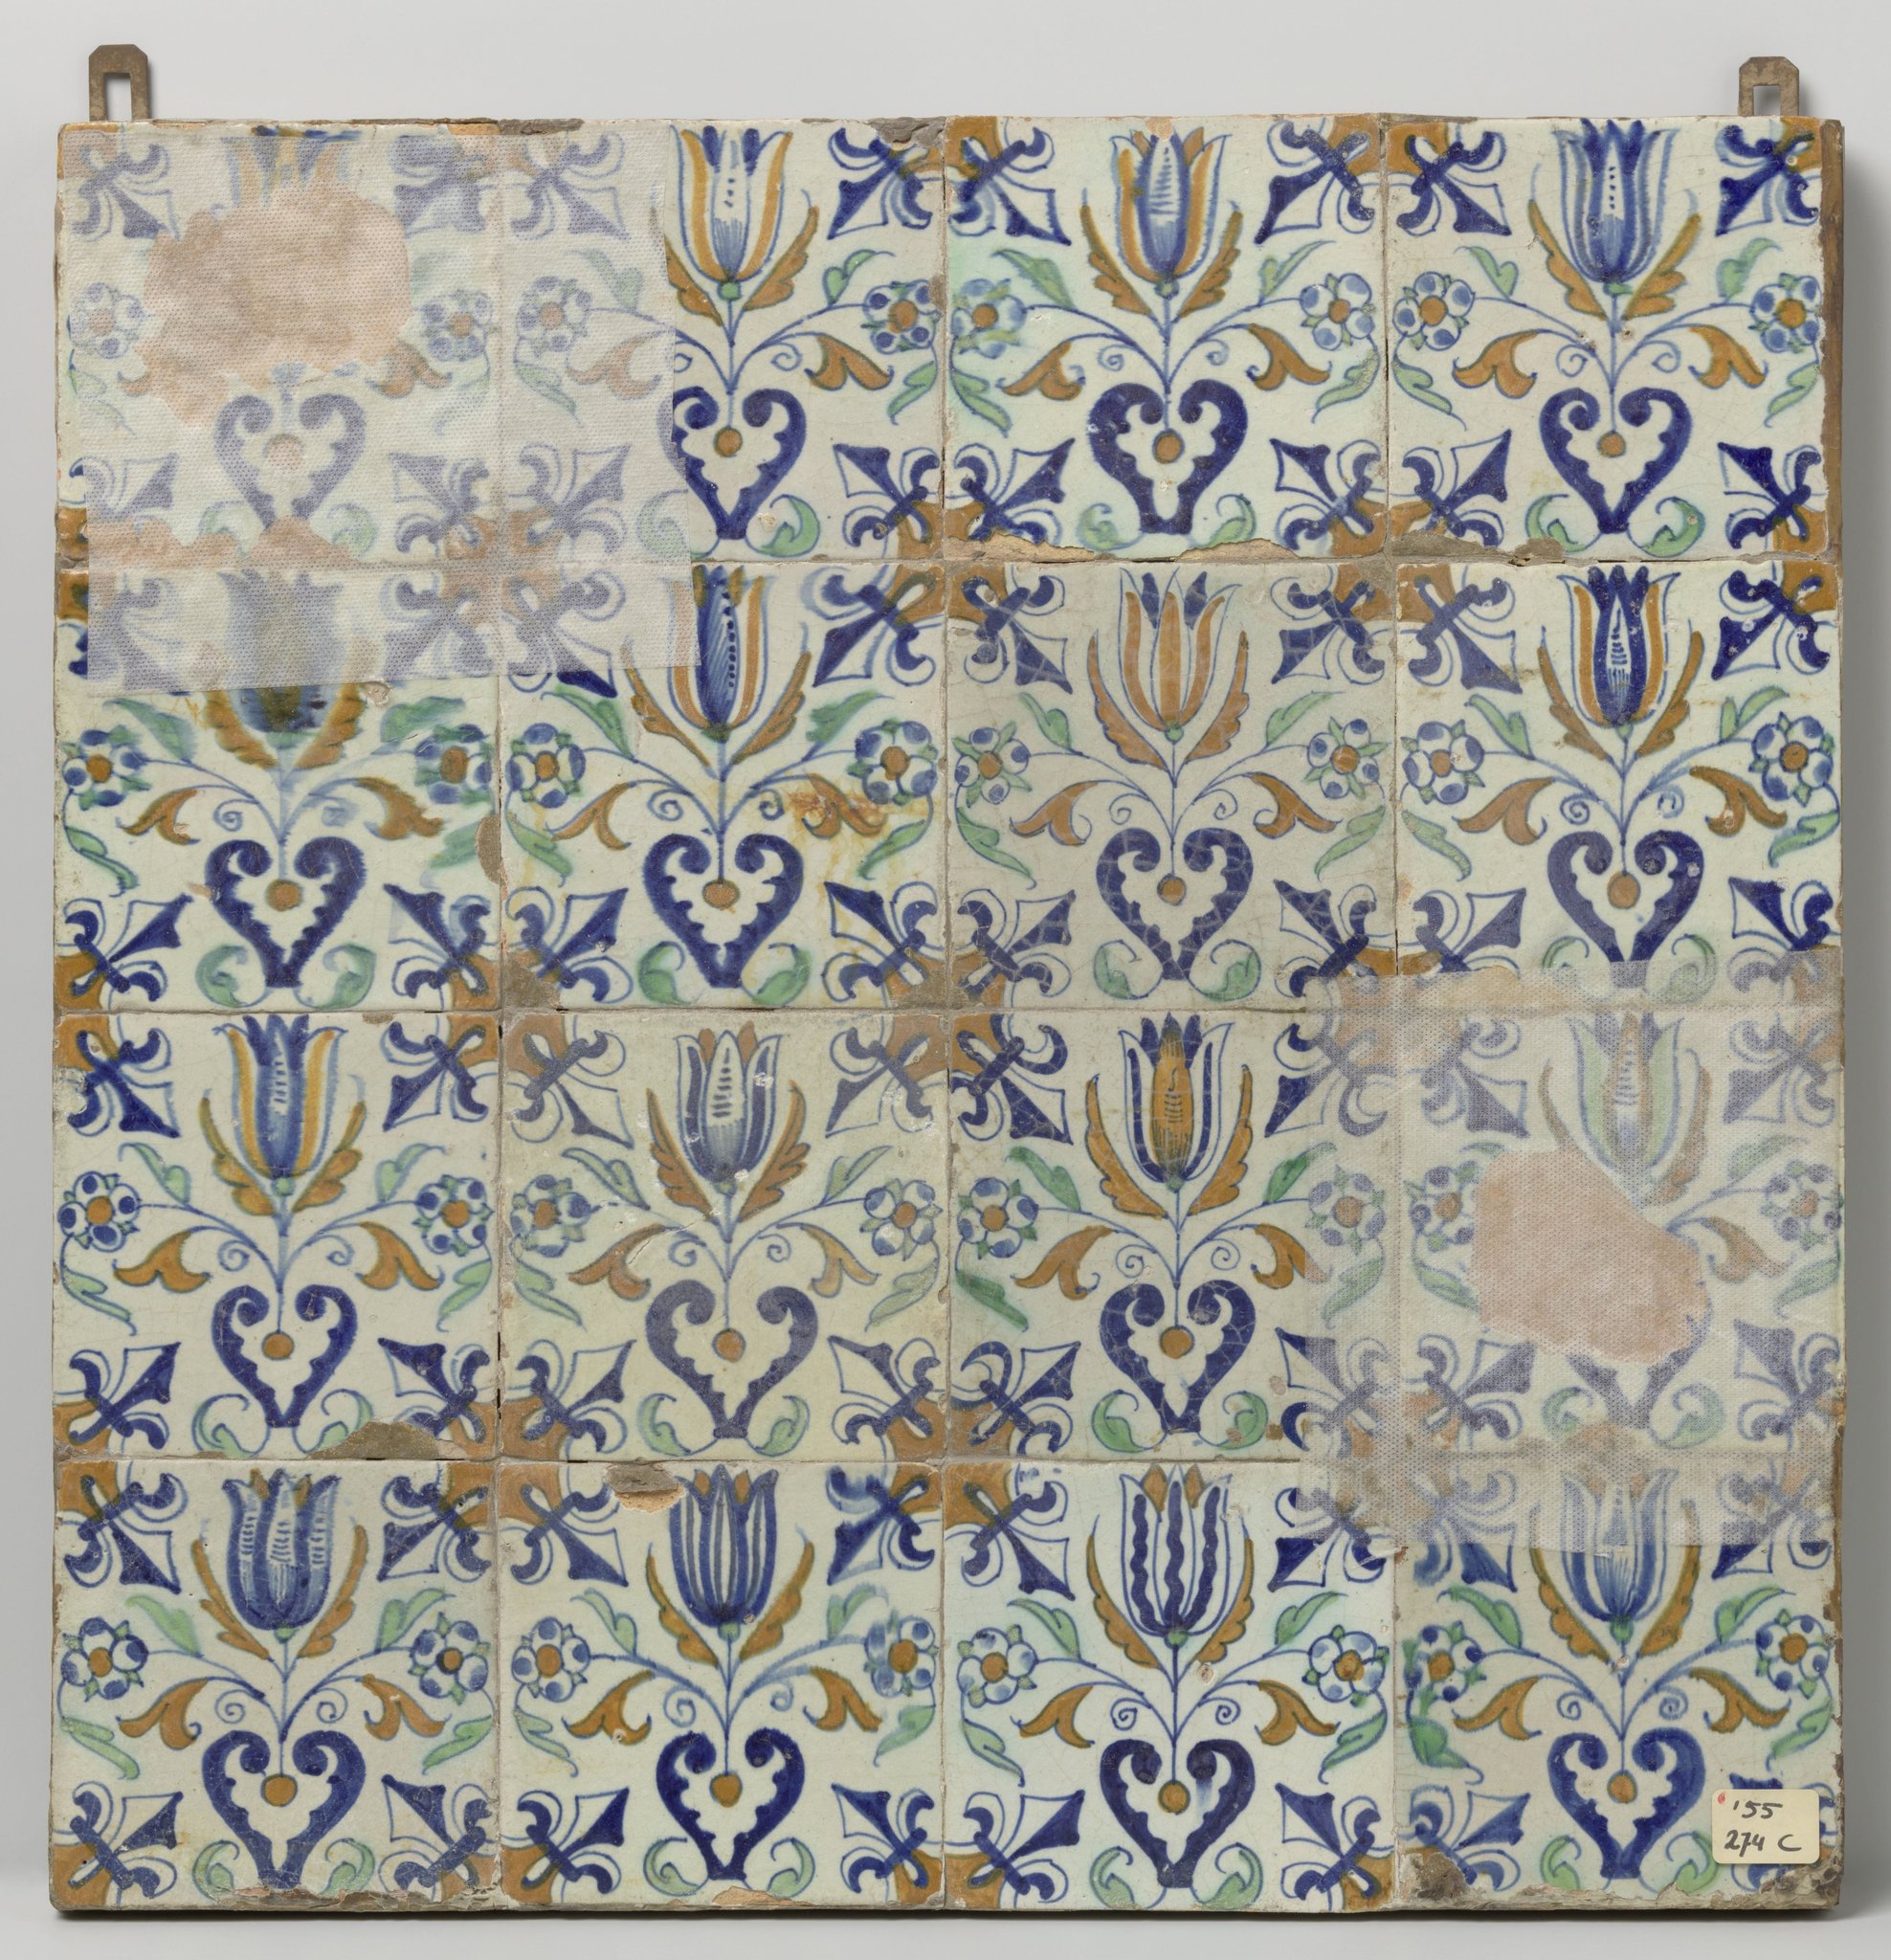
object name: tegelveld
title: Veld van zestien tegels met tulpen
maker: Anonymous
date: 1610-1630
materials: earthenware, glaze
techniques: maiolica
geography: netherlands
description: Veld van zestien tegels (4 x 4) elk met een veelkleurige (blauw, groen en oranje) tulp in een bloempot of bol. In de hoeken, een lelie.